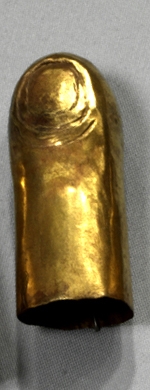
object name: toe stall, group 2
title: Toe stall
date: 1479-1425 BCE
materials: gold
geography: egypt